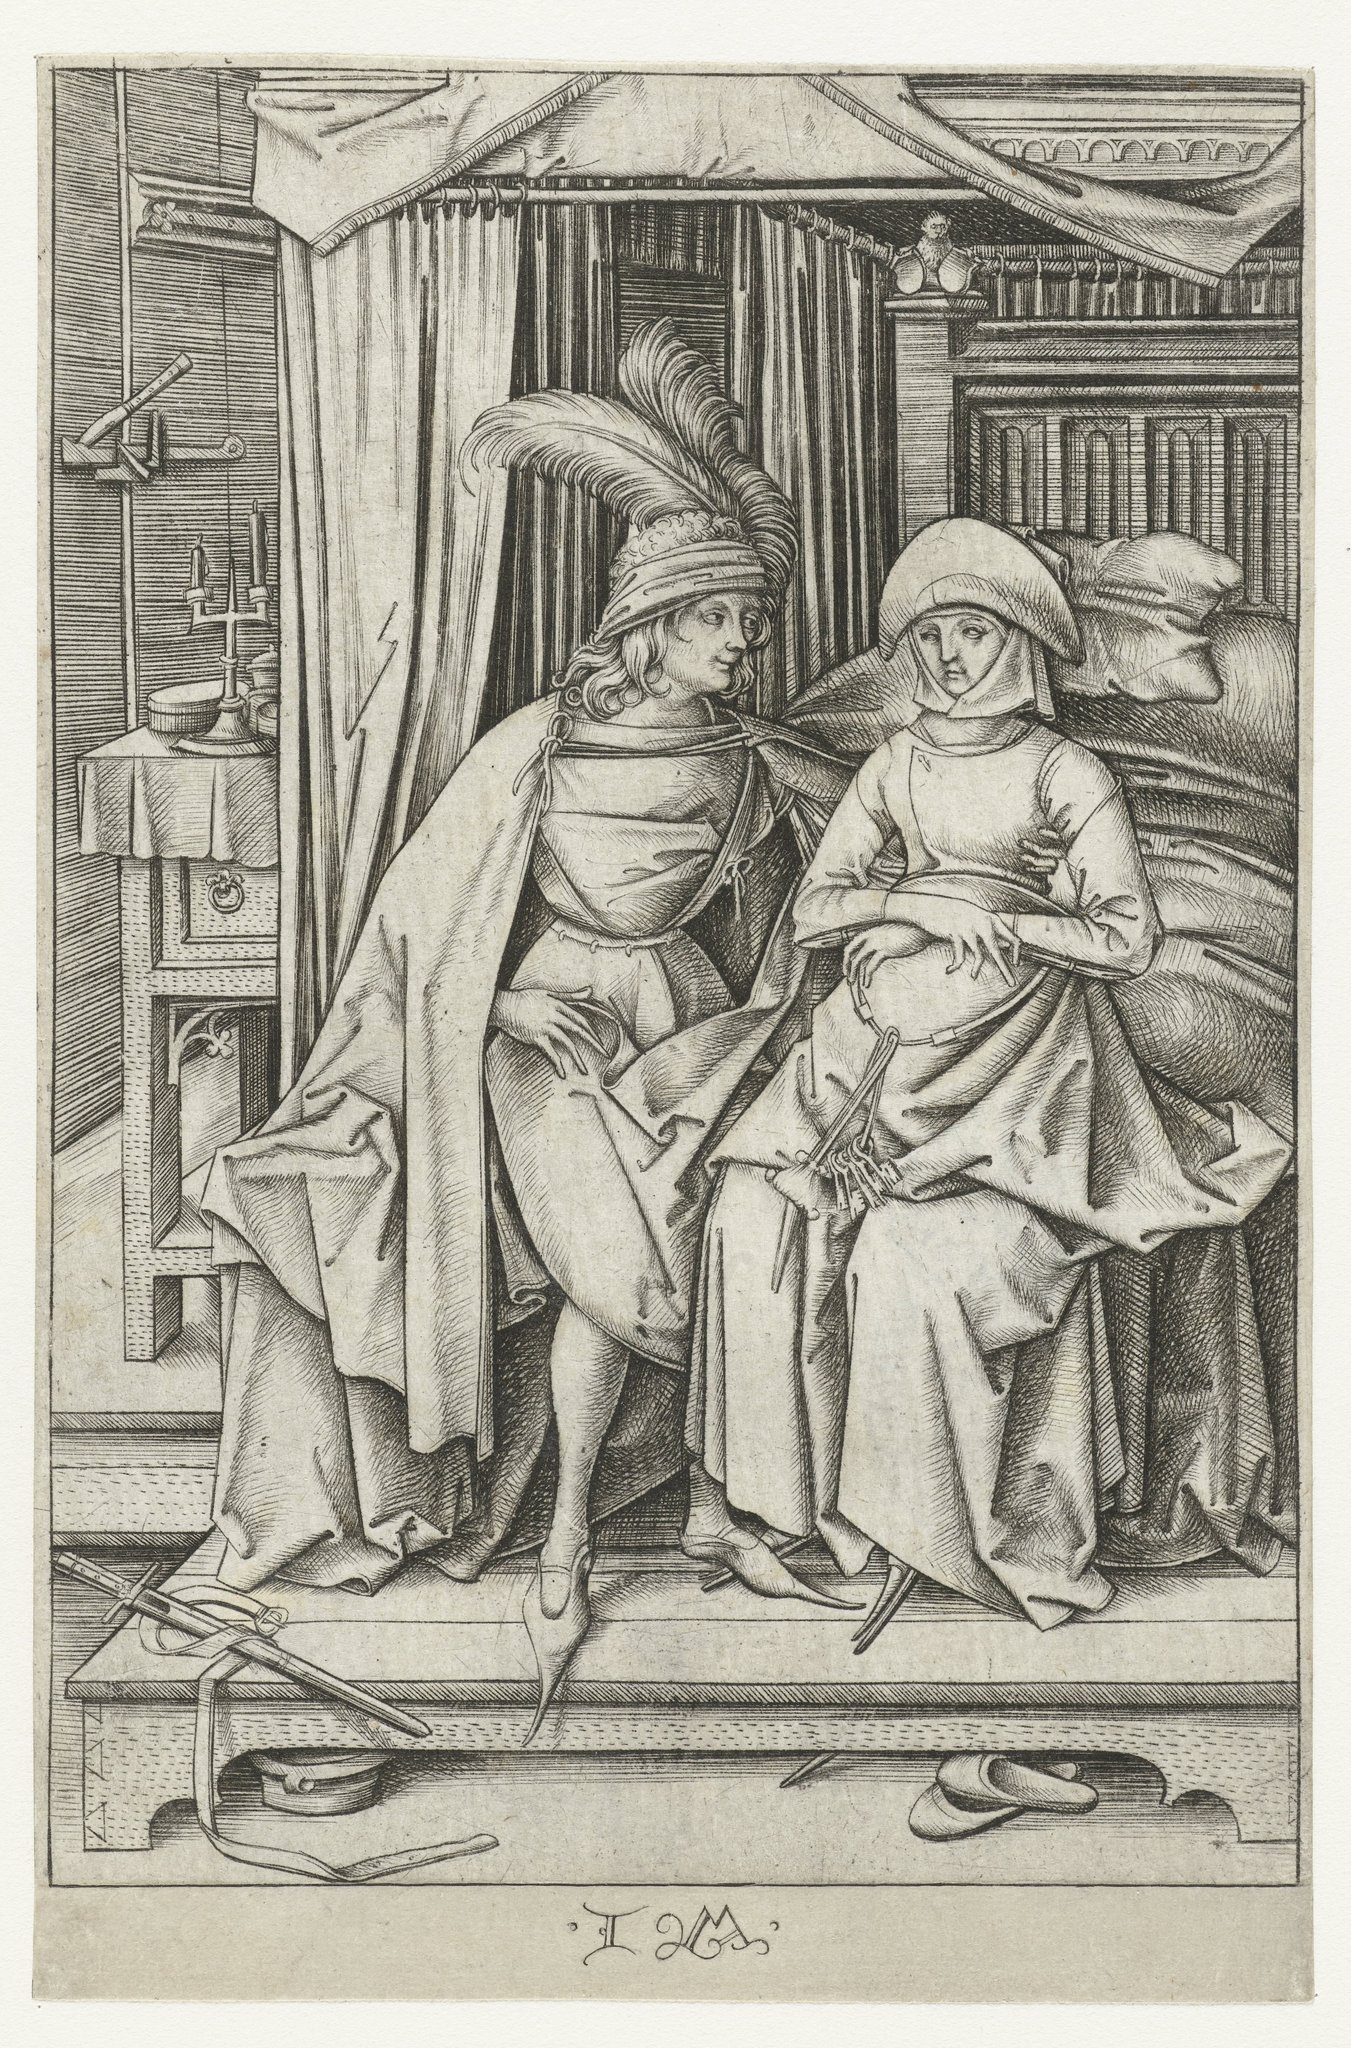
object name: print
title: Paar gezeten op een hemelbed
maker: israhel van meckenem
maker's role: print maker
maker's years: 1440-1517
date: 1475-1503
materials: paper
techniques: engraving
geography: bocholt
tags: head-gear: turban (+ men's clothes), head-gear: turban (+ feathers used for clothes), bed with tester, slippers, belt, girdle, waistband, head-gear: cap (+ women's clothes), clothes, costume (+ women's clothes), clothes, costume (+ men's clothes), couple of lovers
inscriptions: collector's mark: Lugt 2228a, collector's mark: Lugt 1606, collector's mark: Lugt 2398, collector's mark: Lugt 2510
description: Kleding vrouw: halfronde kap met hoofddoek die onder de kin sluit; overkleed met hoge sluiting, om het middel een ceintuur met beursje en sleutelbos. Tootschoenen. Kleding man: muts in de vorm van een halve bol, zonder rand, vermoedelijk van bont. De muts is versierd met een gedrapeerd lint en grote struisveren. Tootschoenen. Huisslofjes (slippers) op de grond. Datering kleding: ca. 1475-1485. Ihle p. 8: 11D: Man tracht de vrouw te verleiden want de klink van de duer is met een mes vastgezet zodat er niemand binnen kan komen. Man is modieus gekleed met tulband-achtige muts met veren. Wambuis met diepe uitsnijding tot de taille...(zie beschrijving bij RP-P-2002-192). Vrouw draagt een gevouwen muts op haar hoofddoek. Japon met losse mouwen met splitten van pols tot elleboog. Mouwen reiken tot onder de schouders. Overkleed al uitgedaan ??